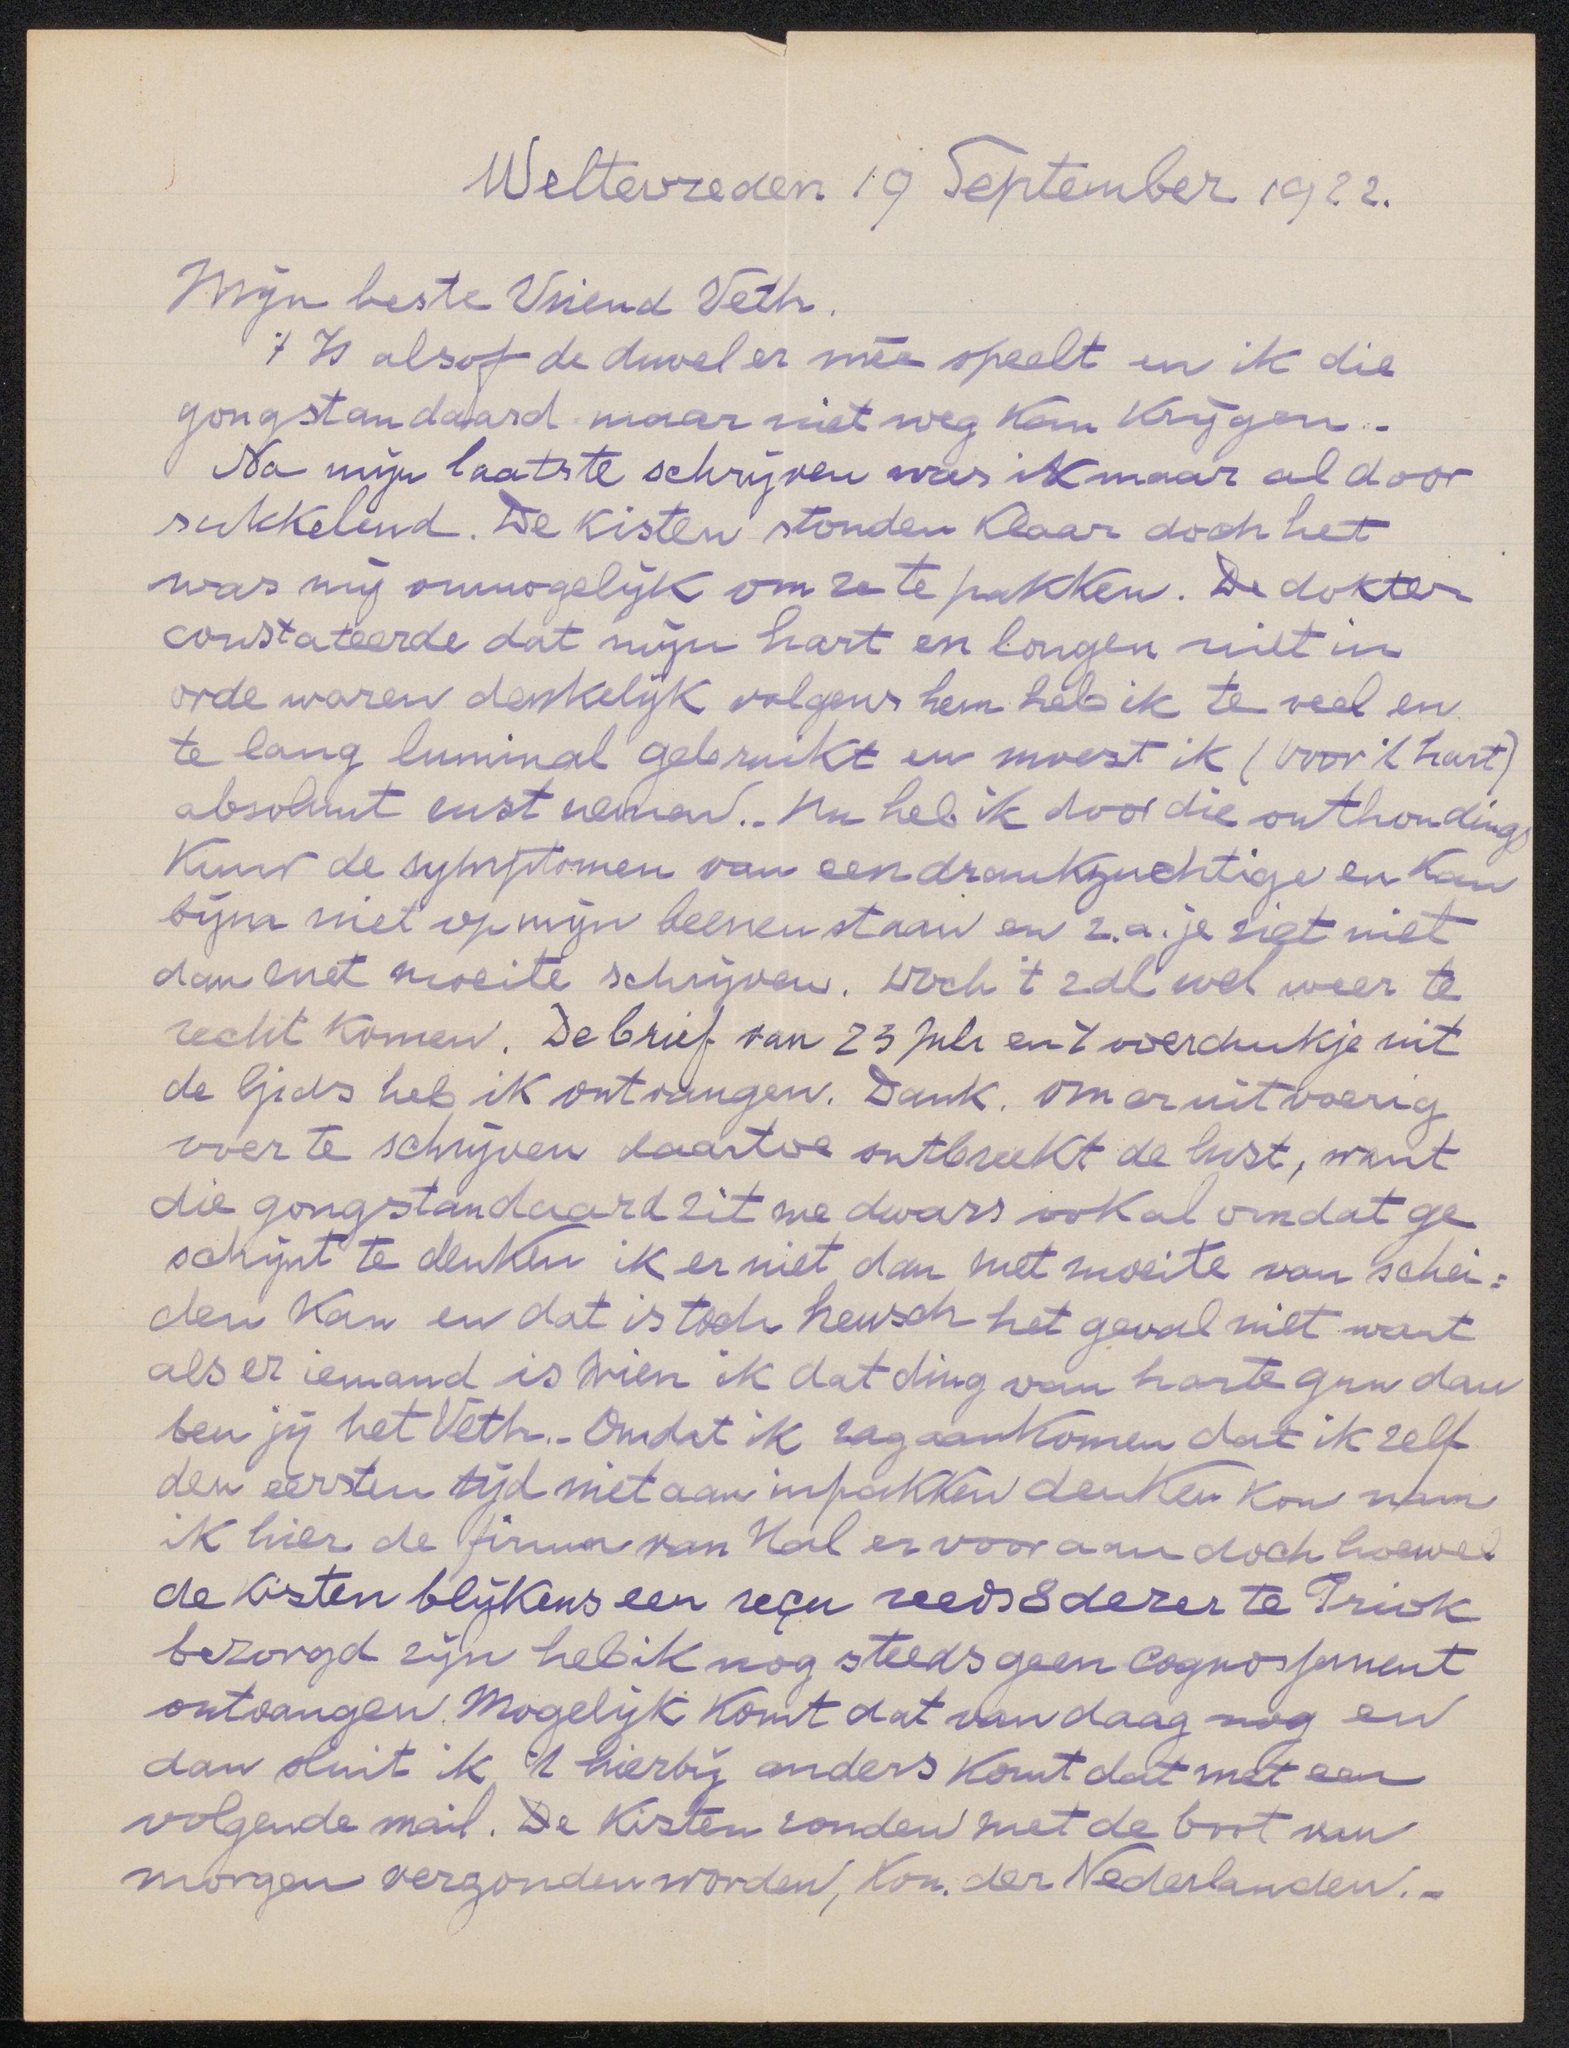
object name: letter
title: Brief aan Jan Veth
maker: jean pierre moquette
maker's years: 1856-1927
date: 1922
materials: ink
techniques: pen, writing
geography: weltevreden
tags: leiden, dordrecht, amsterdam, painter, draughtsman, designer, jan veth, c.c. delprat, diseases, batavia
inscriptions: collector's mark: ‘RPK’